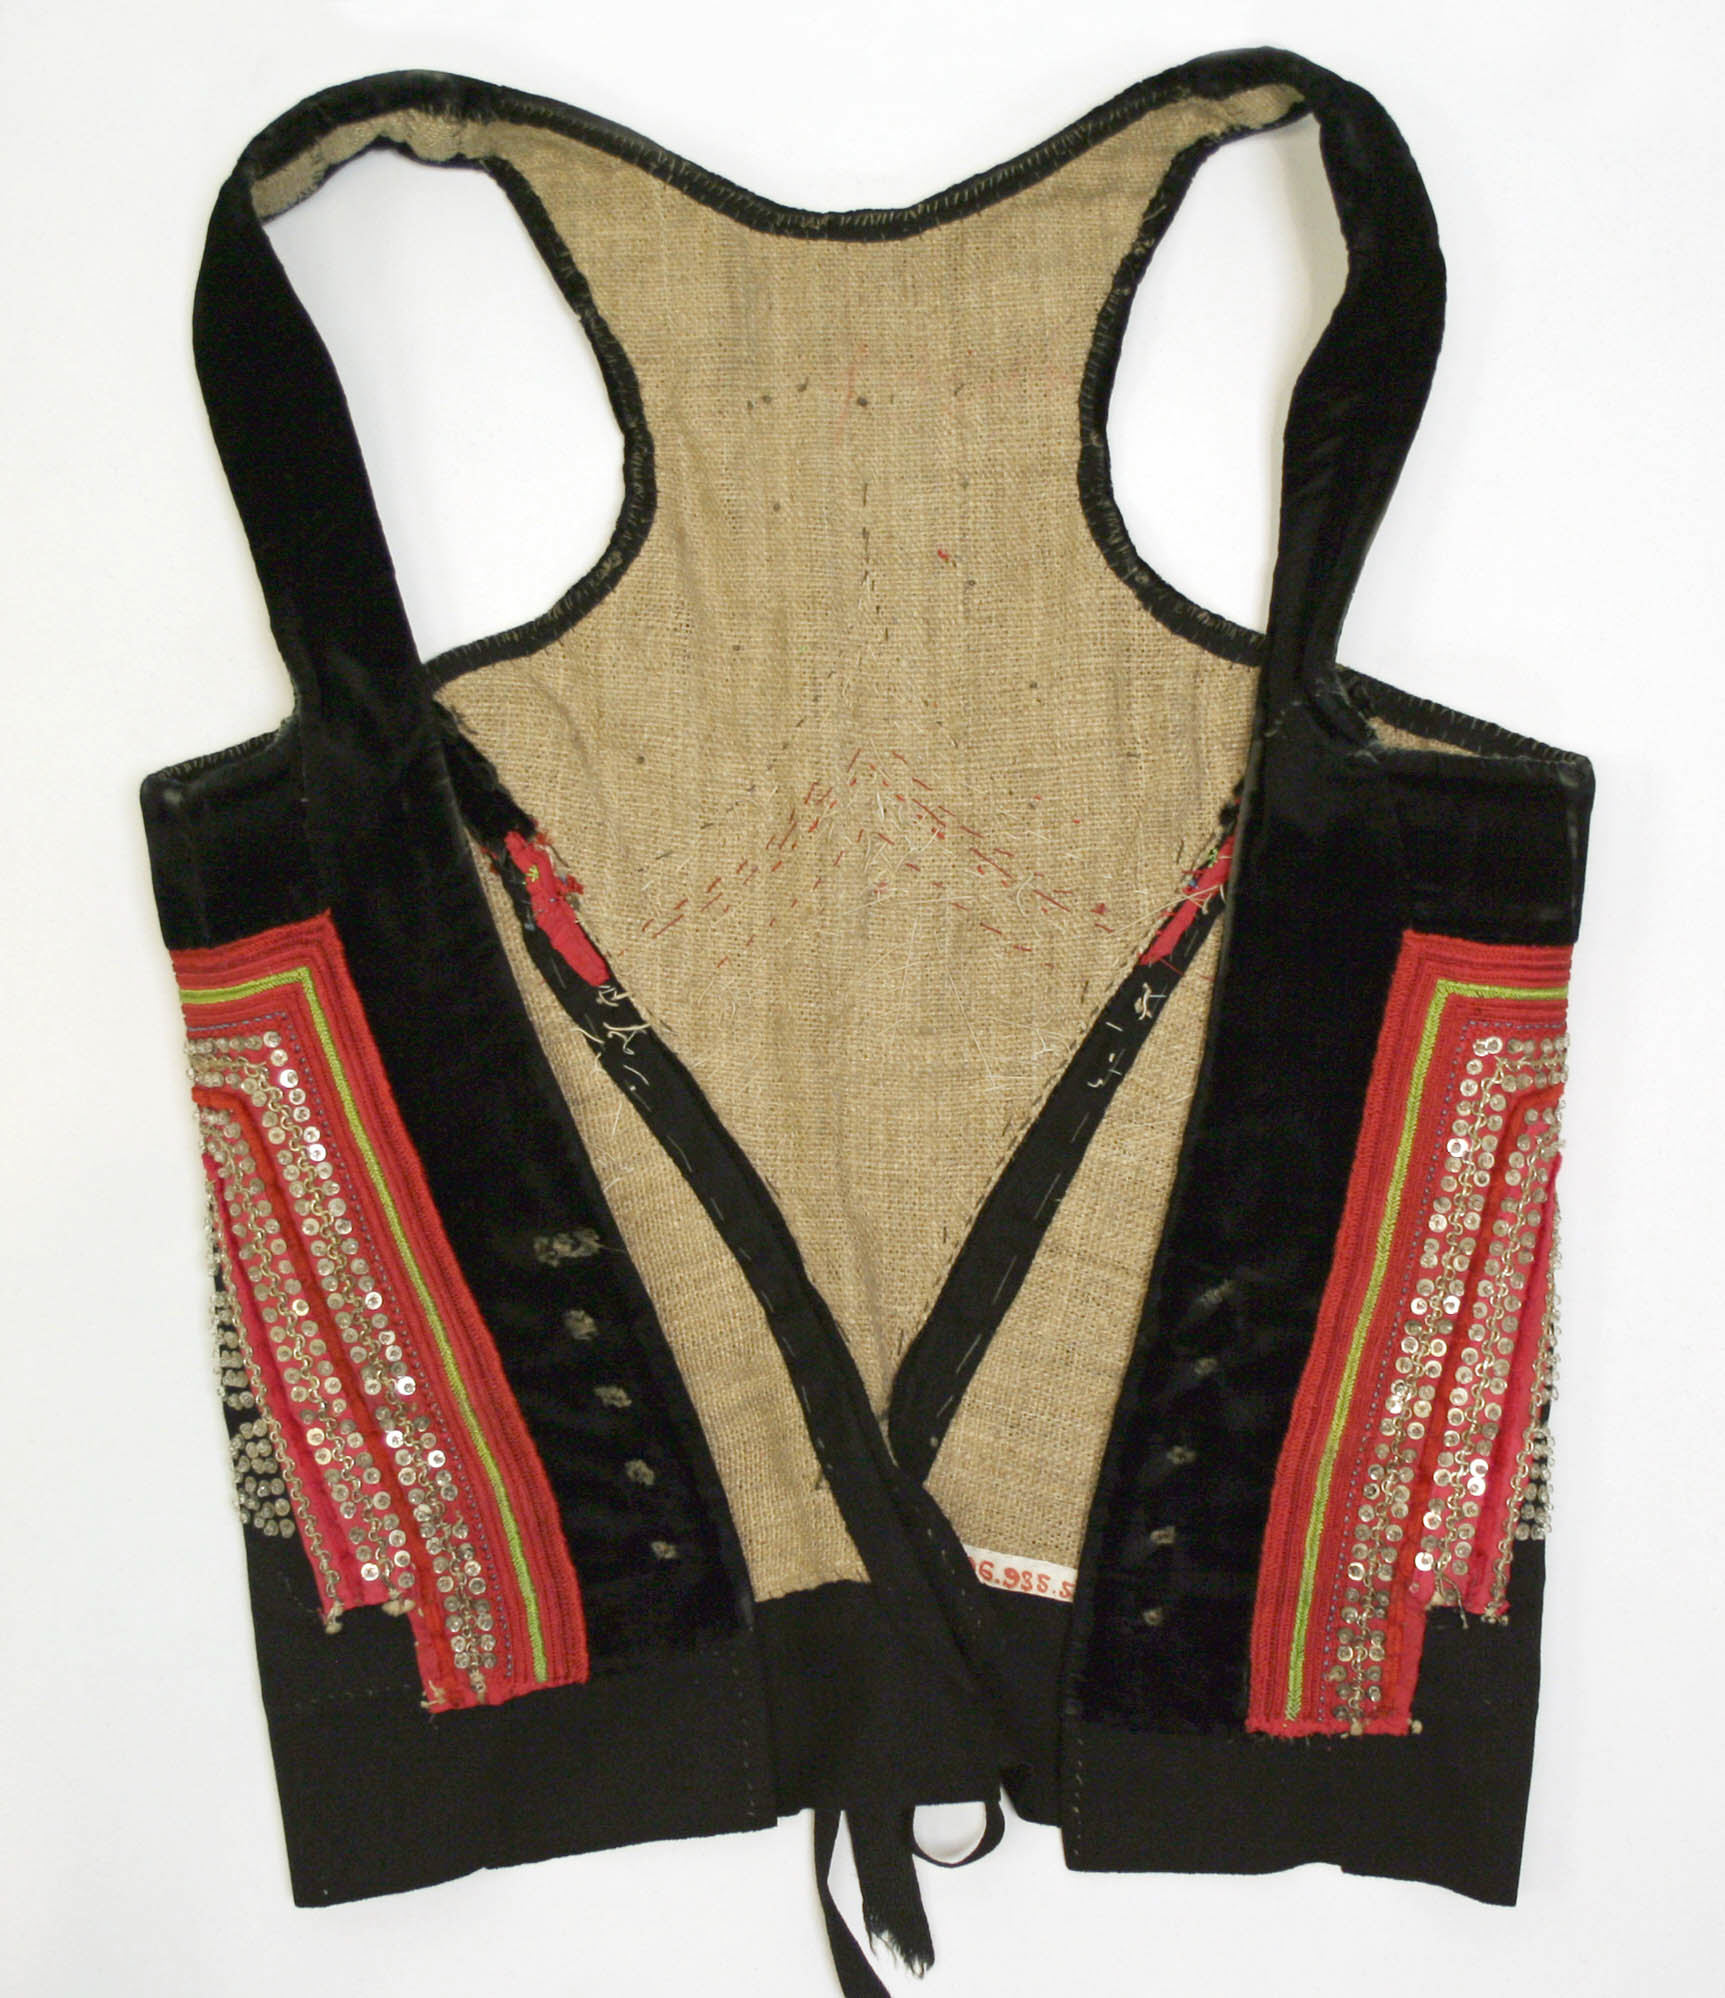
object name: bodice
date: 1801-1900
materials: glass, metal thread, thread, wool